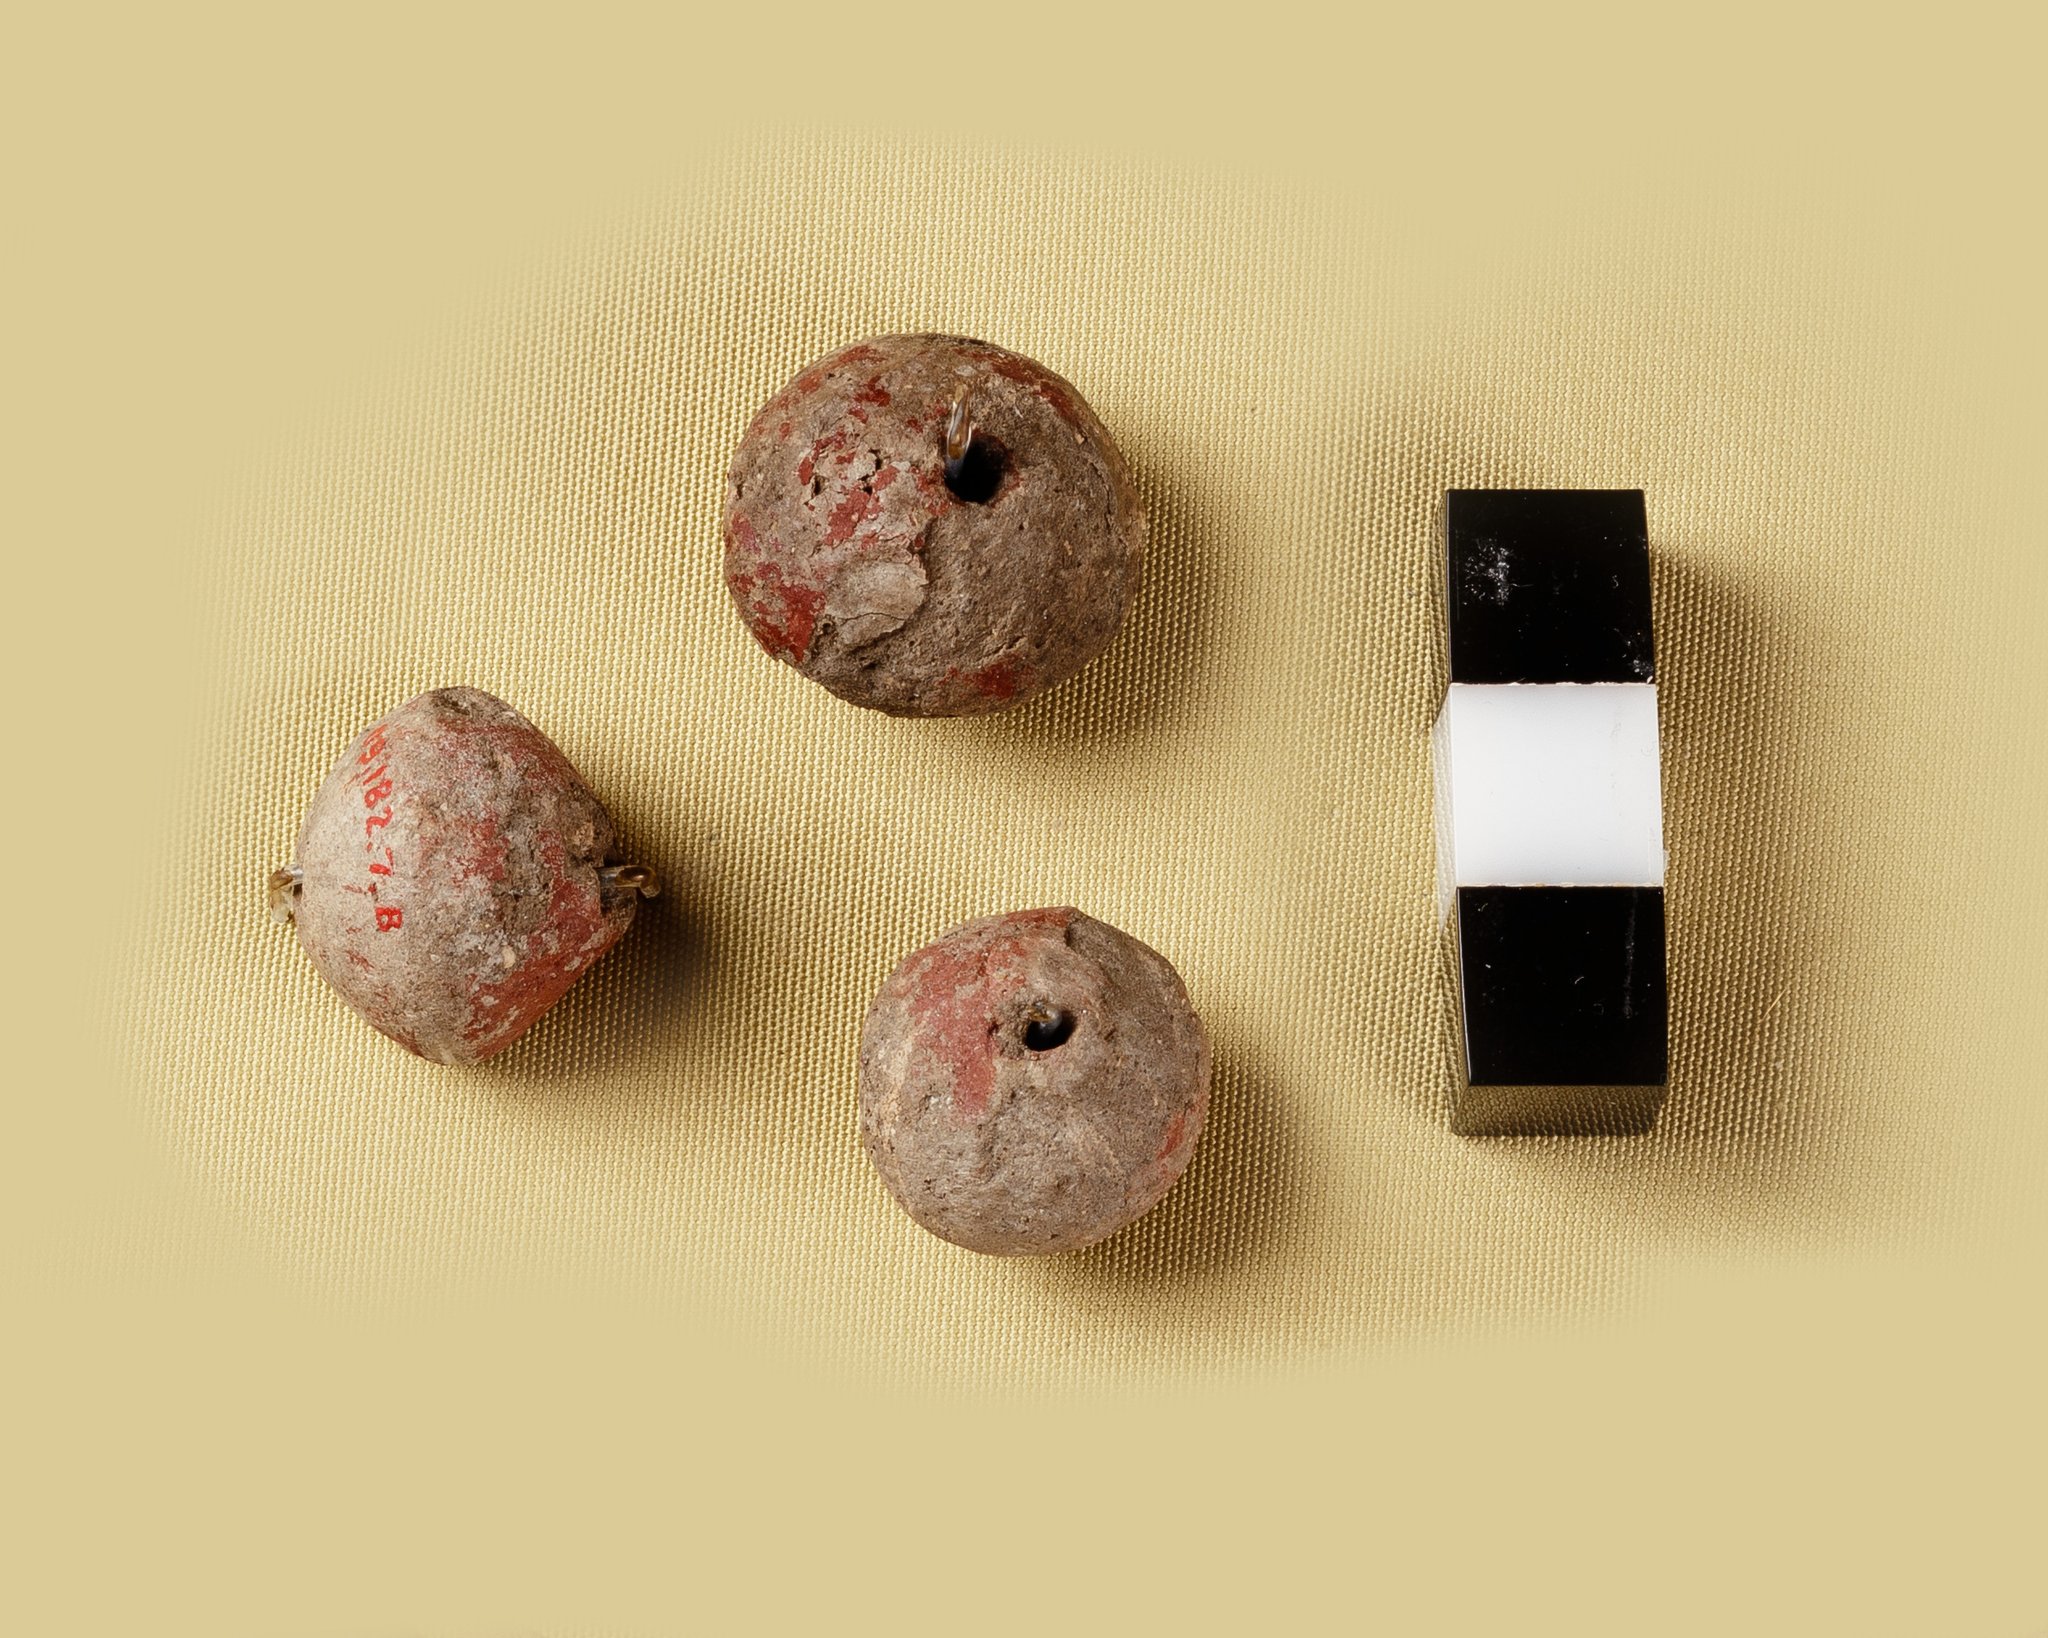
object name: bead, 3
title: Three large spherical beads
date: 3900-3650 BCE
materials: clay, pigment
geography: egypt